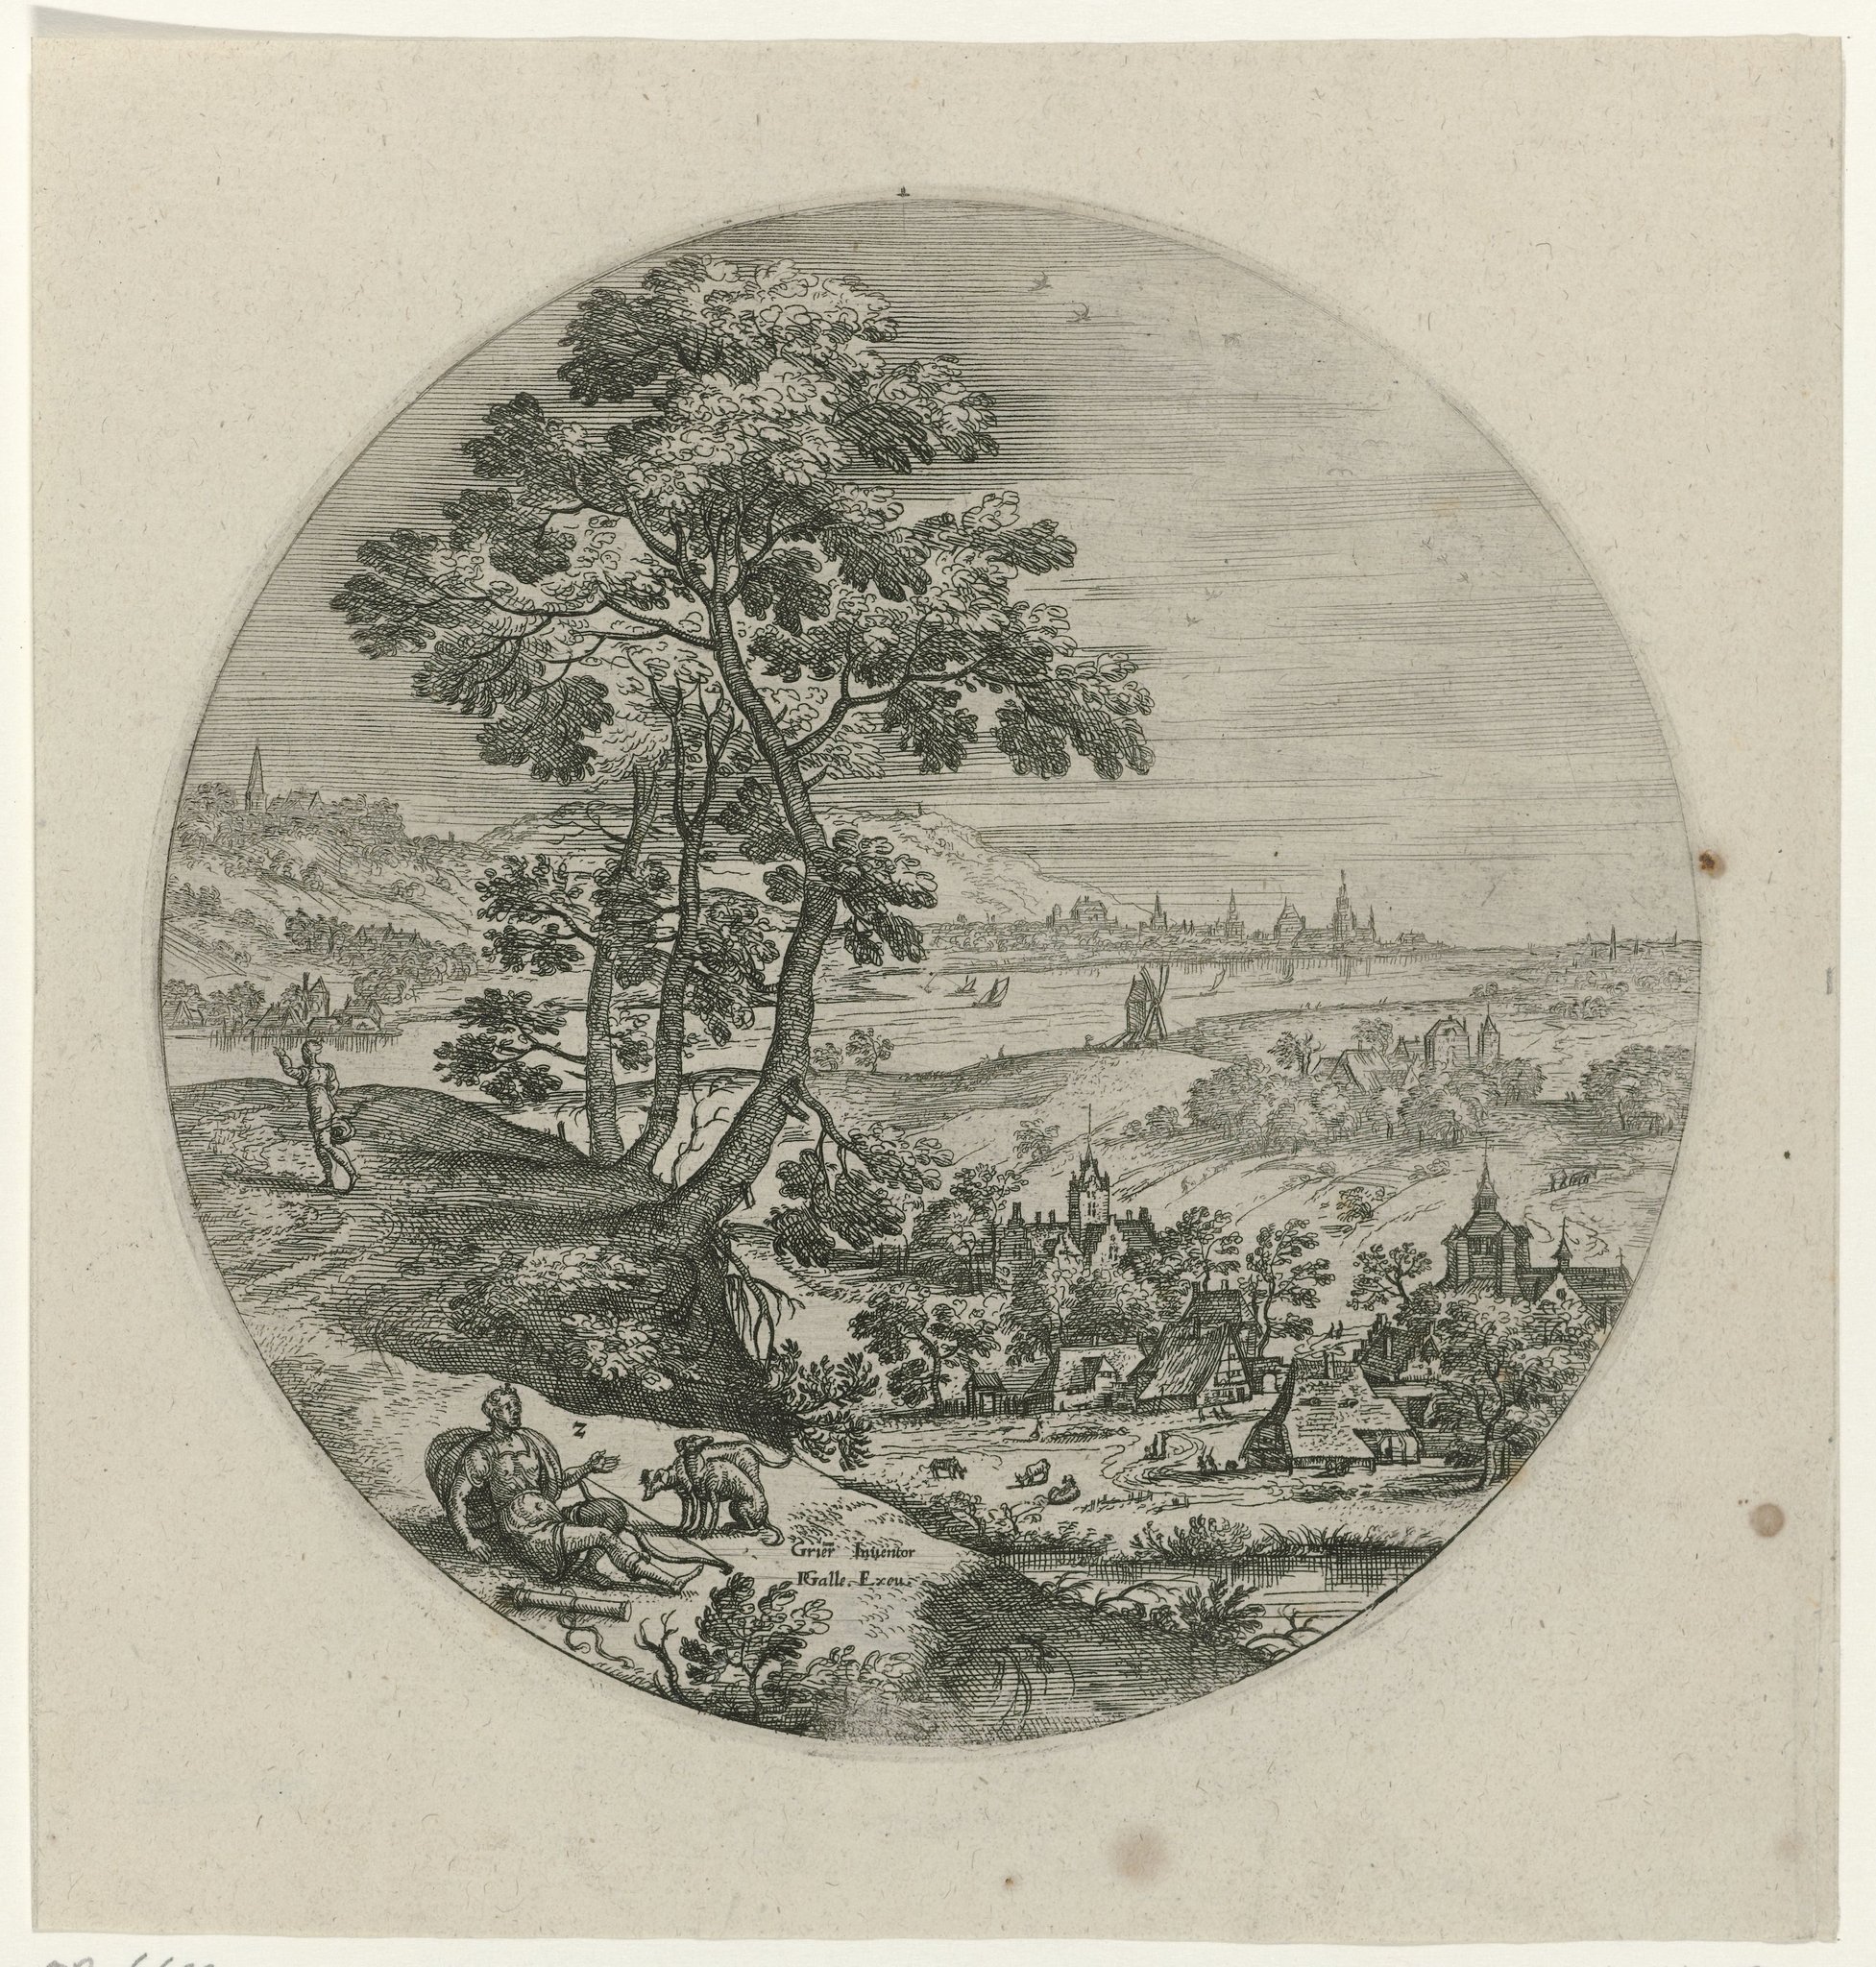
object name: print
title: Cephalus besluit op jacht te gaan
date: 1547-1612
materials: paper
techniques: etching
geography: antwerp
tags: cephalus and procris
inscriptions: collector's mark: Lugt 2228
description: Cephalus zit op de grond. Naast hem zijn pijl en boog en zijn jachthonden. Procris wandelt in de achtergrond terug naar huis. De prent is deel van een serie over het mythologische verhaal van Procris en Cephalus.